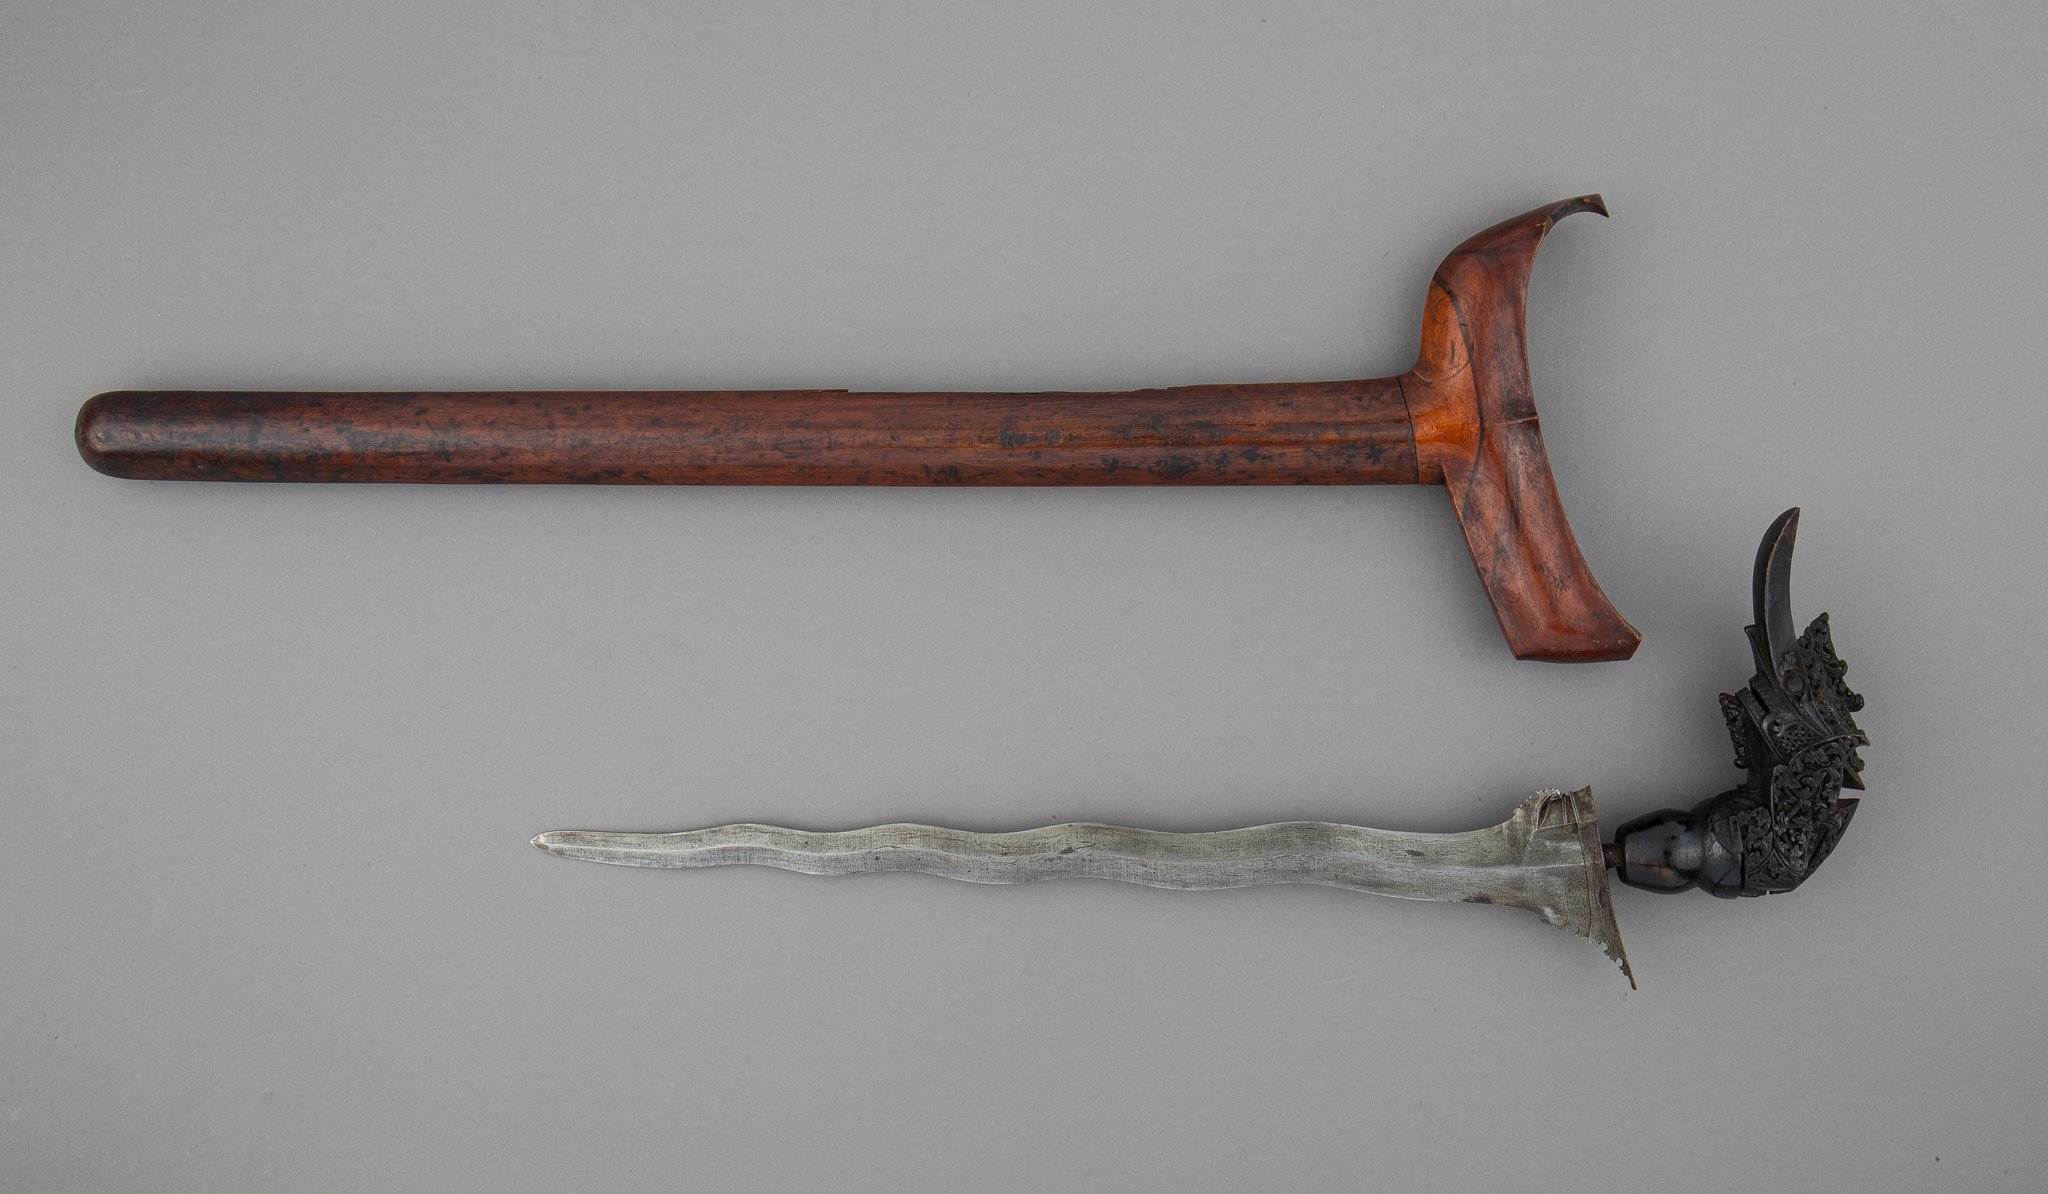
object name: kris with sheath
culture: malayan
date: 1701-1900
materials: steel, wood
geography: malay peninsula